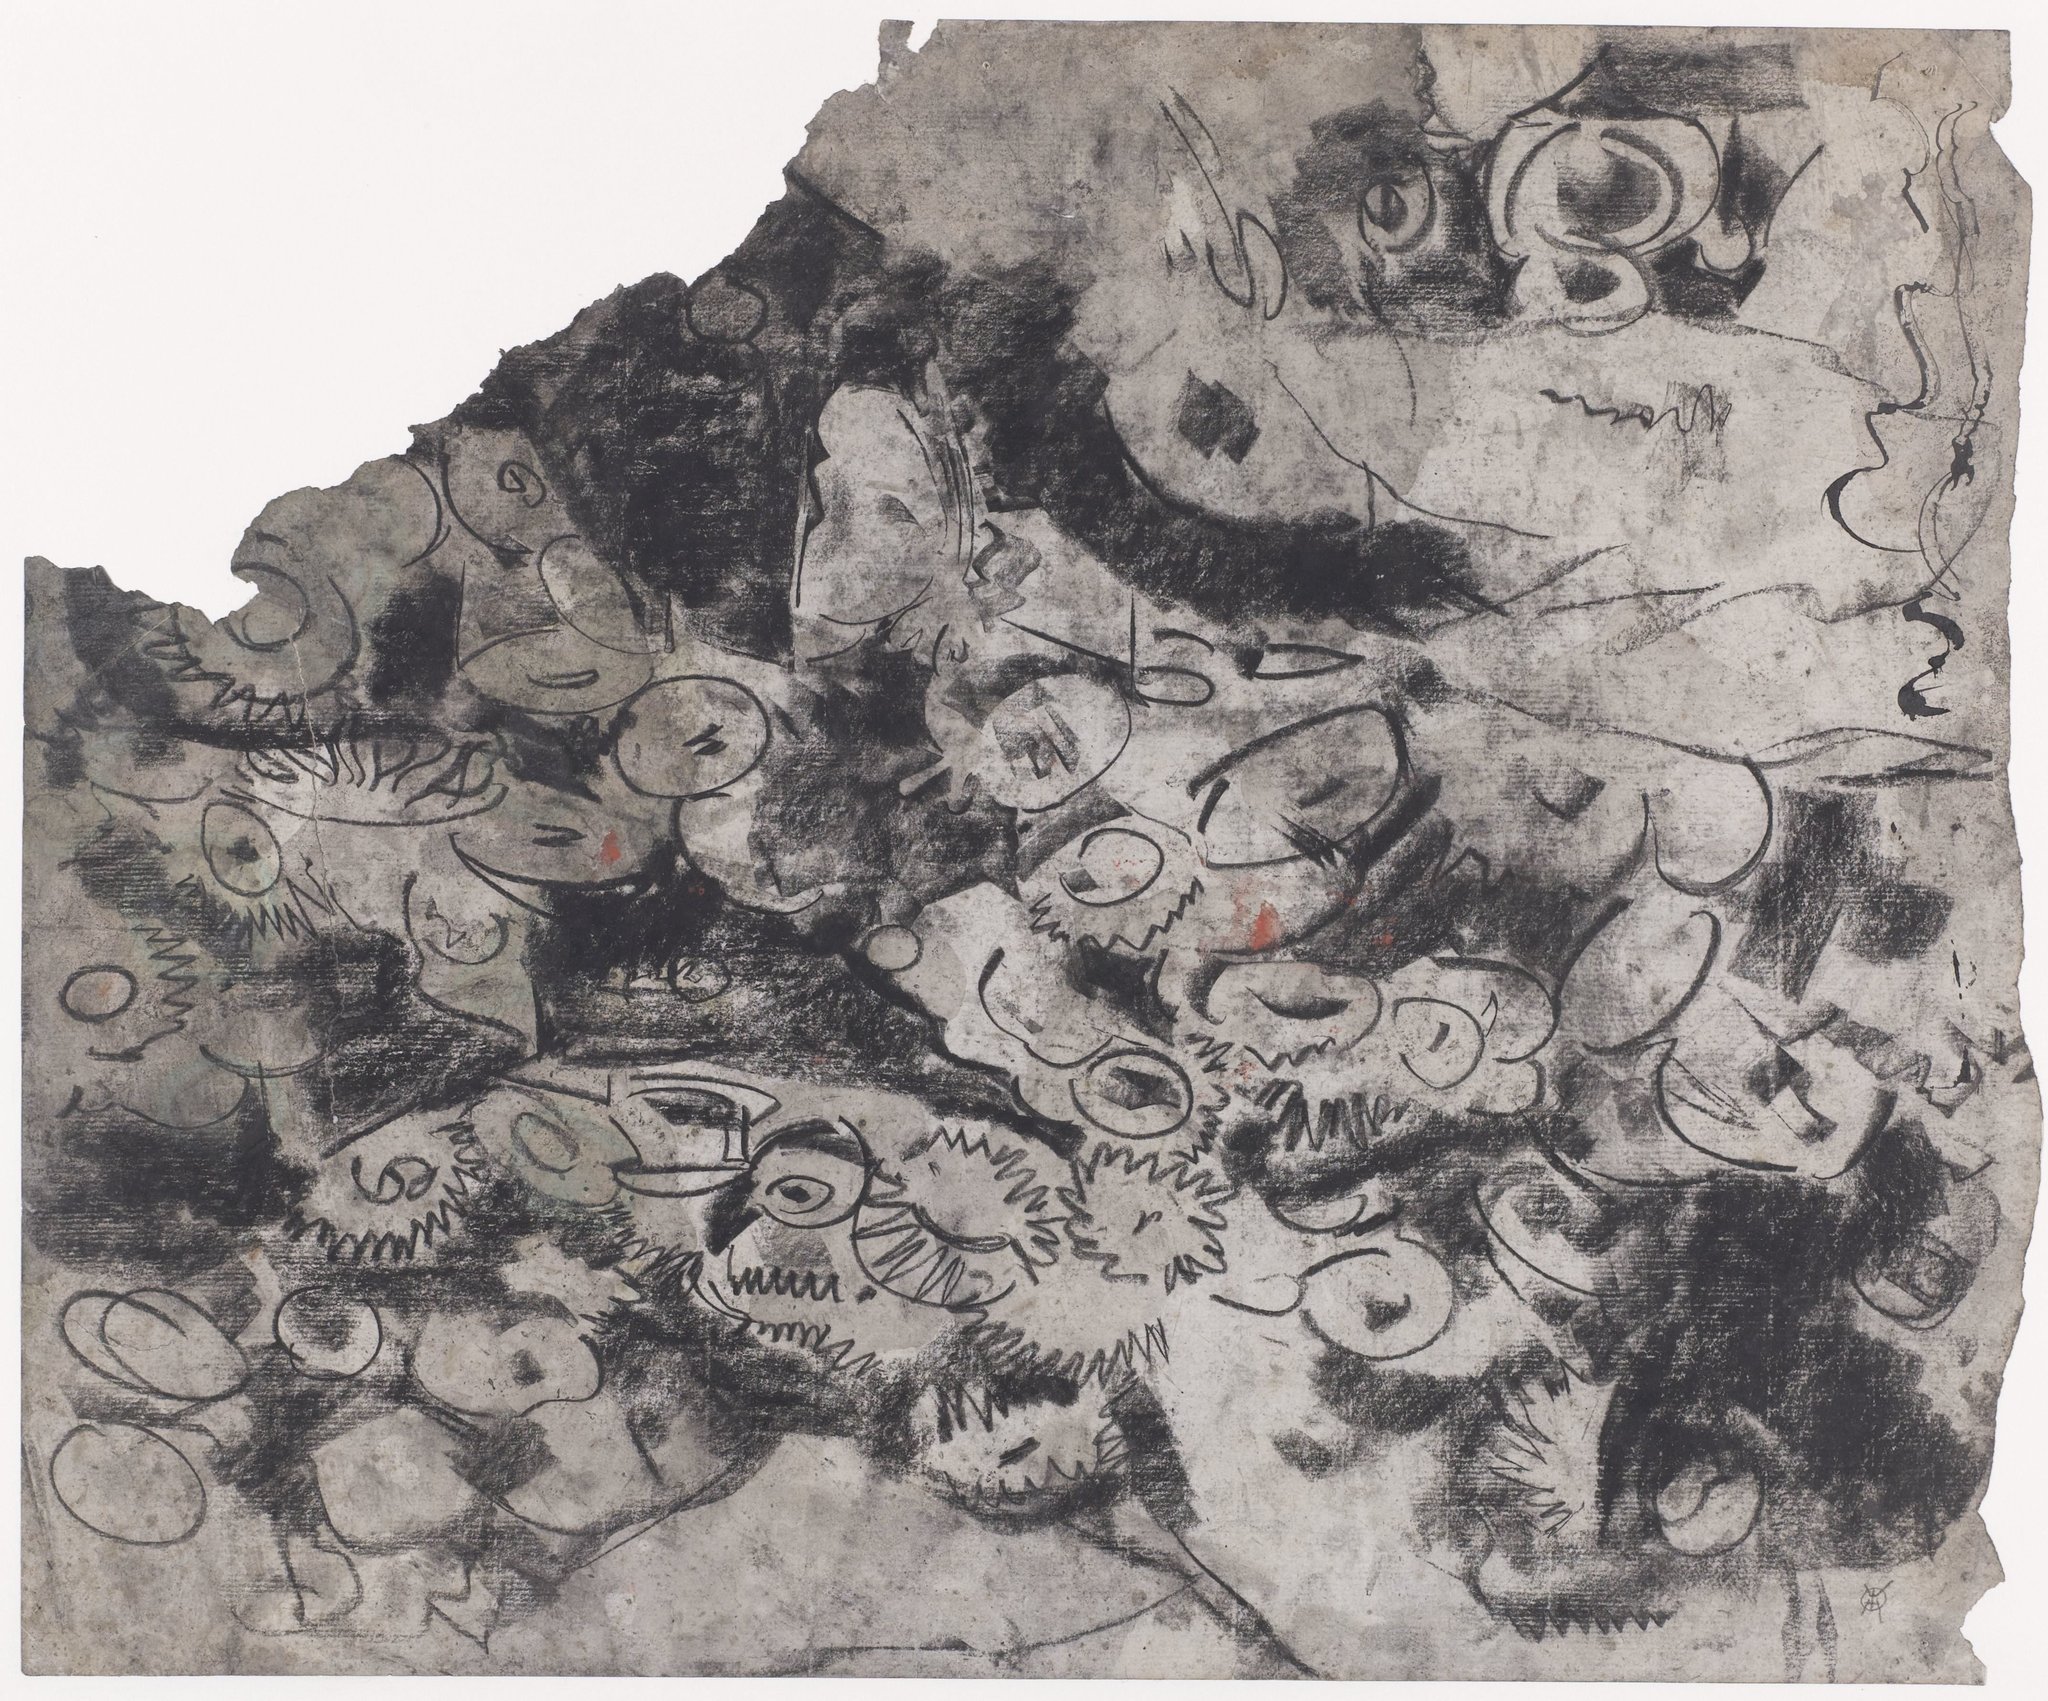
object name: drawing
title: Zeeanemonen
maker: gerrit willem dijsselhof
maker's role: designer, draughtsman, print maker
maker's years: 1866-1924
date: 1876-1924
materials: chalk, paper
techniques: brush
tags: coelenterata: sea anemone